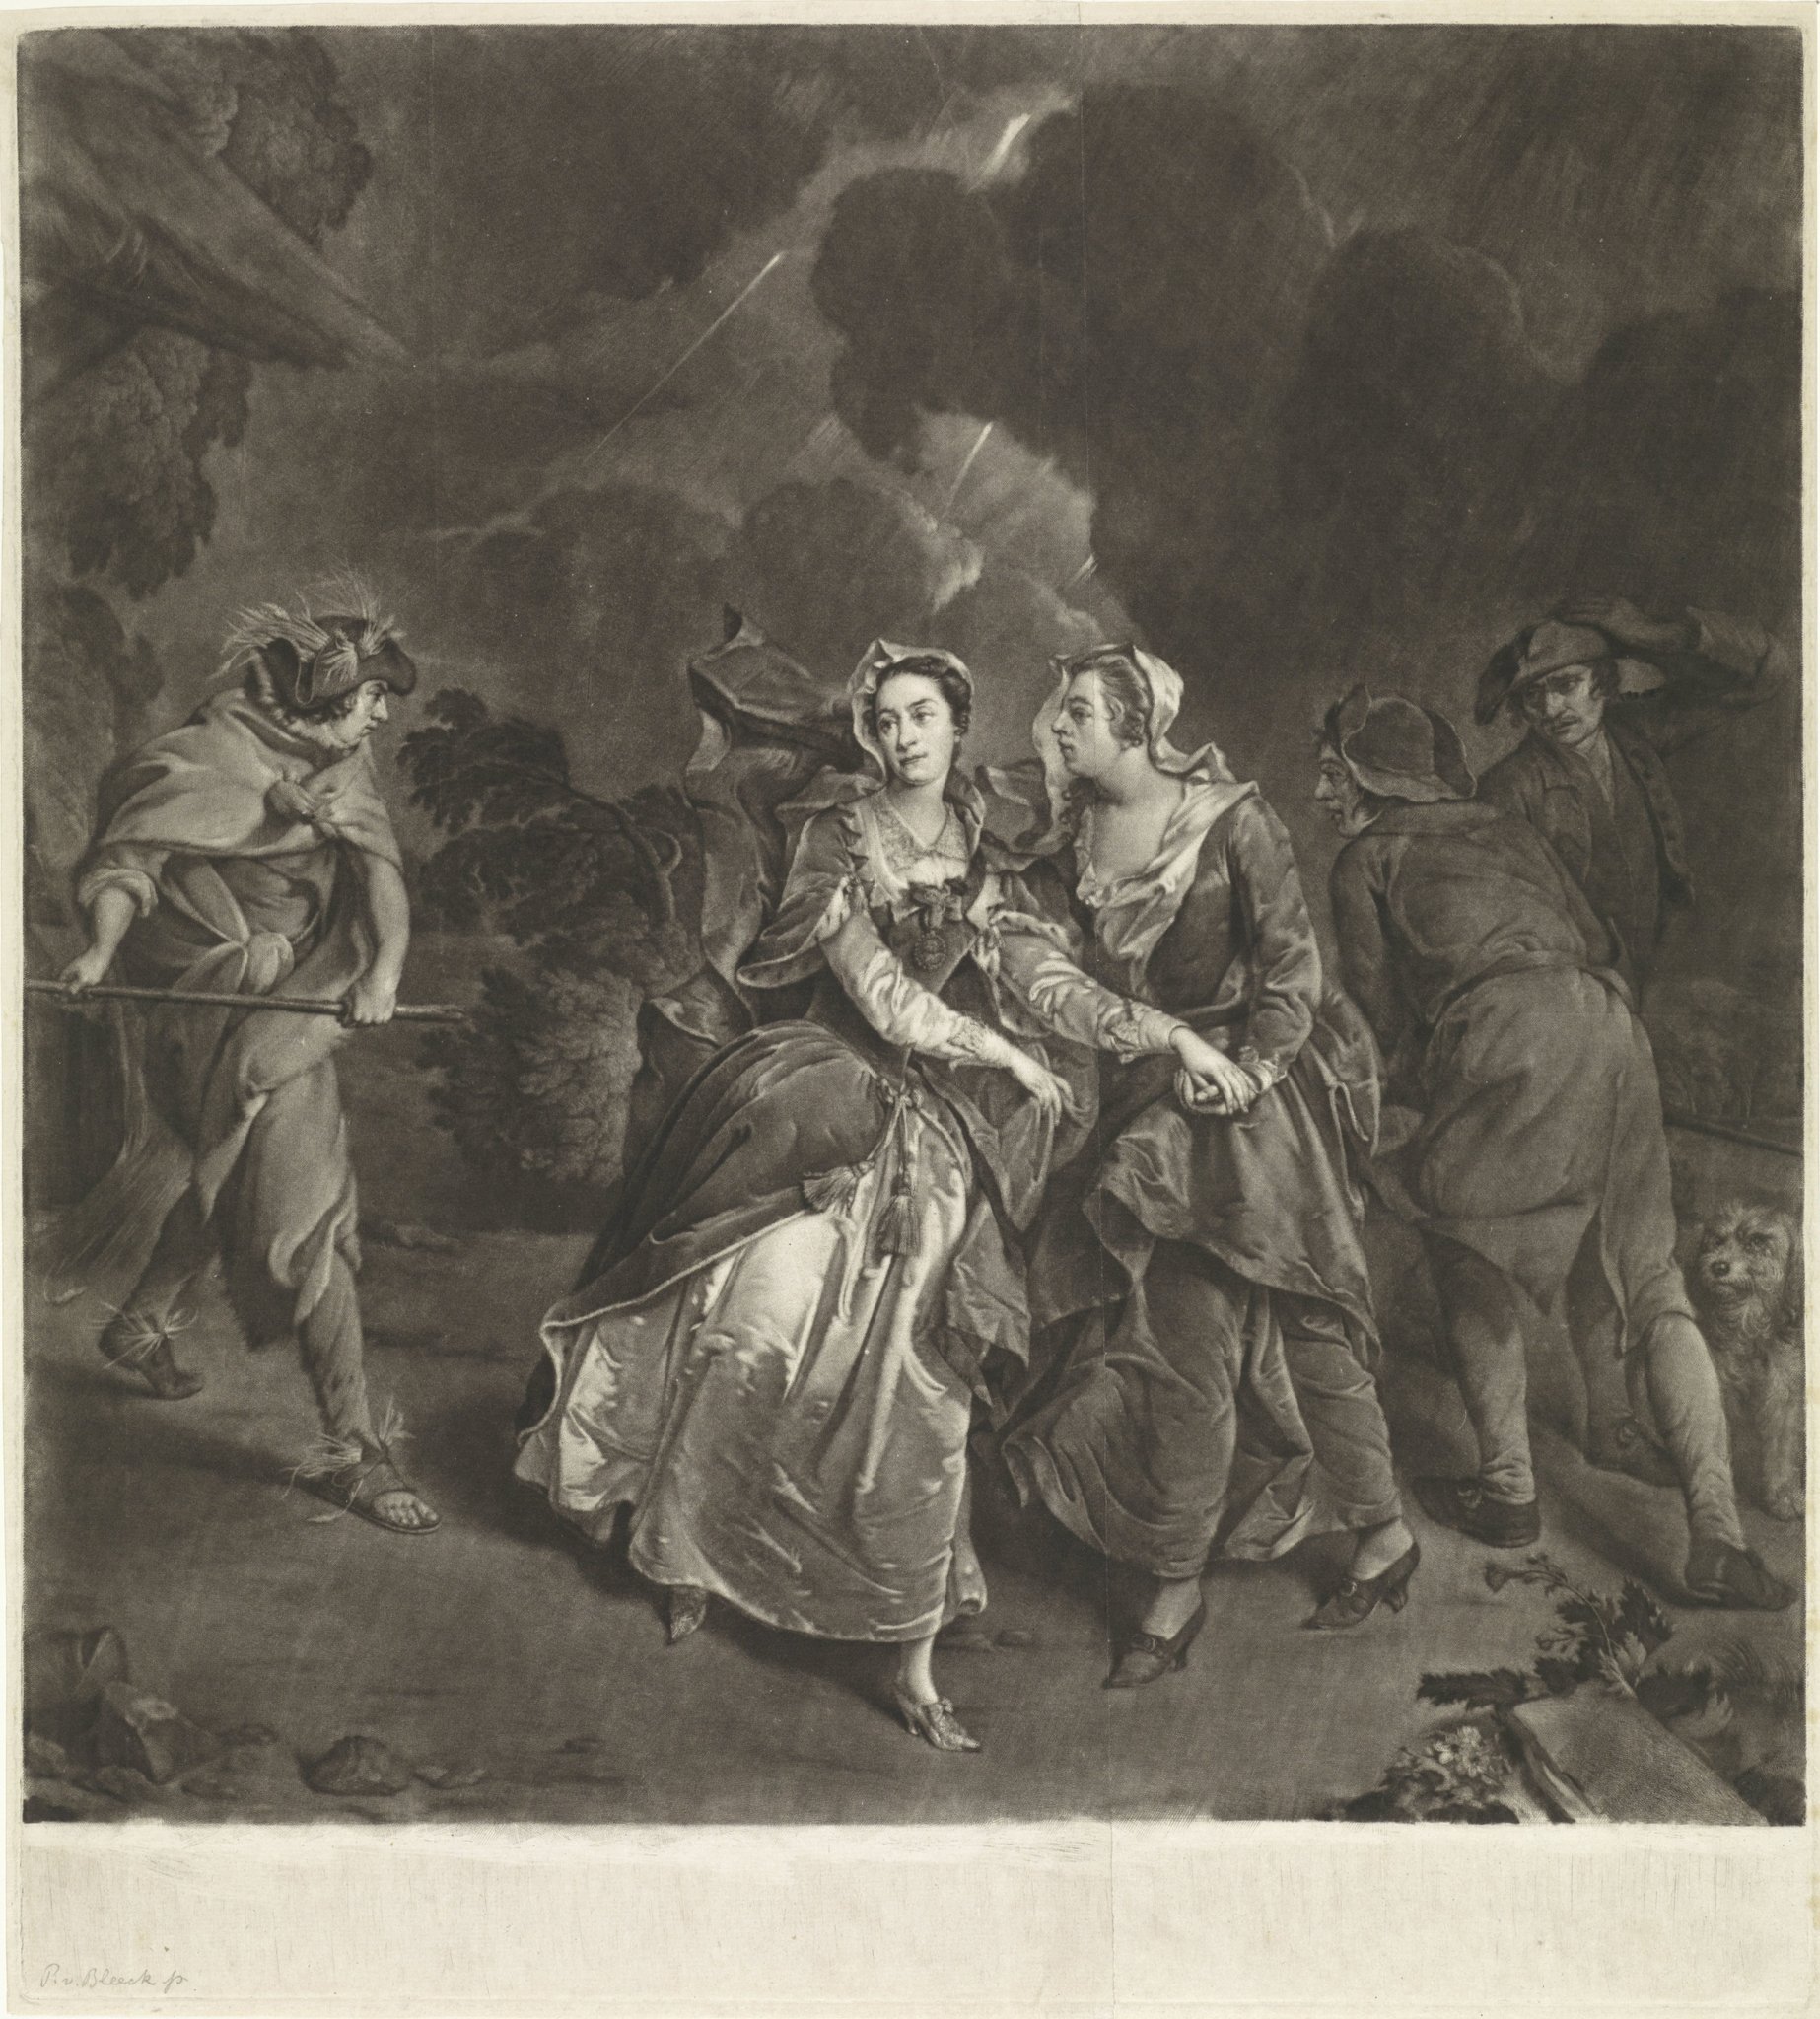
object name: print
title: Actrice Susannah Maria Cibber in de rol van Cordelia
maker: pieter van bleeck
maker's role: print maker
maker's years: 1700-1764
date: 1755-1764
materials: paper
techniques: mezzotint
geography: england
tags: group of actors, troupe; actors on the stage, actress (on the stage), king lear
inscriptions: collector's mark: Lugt 240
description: Scène uit Shakespeares King Lear. Cordelia (actrice Susannah Maria Cibber) staat buiten in de storm. Naast haar een vrouw die haar begeleidt. Achter hen drie mannen en een hond. Een van de mannen heeft stro in zijn hoed en in zijn schoenen.